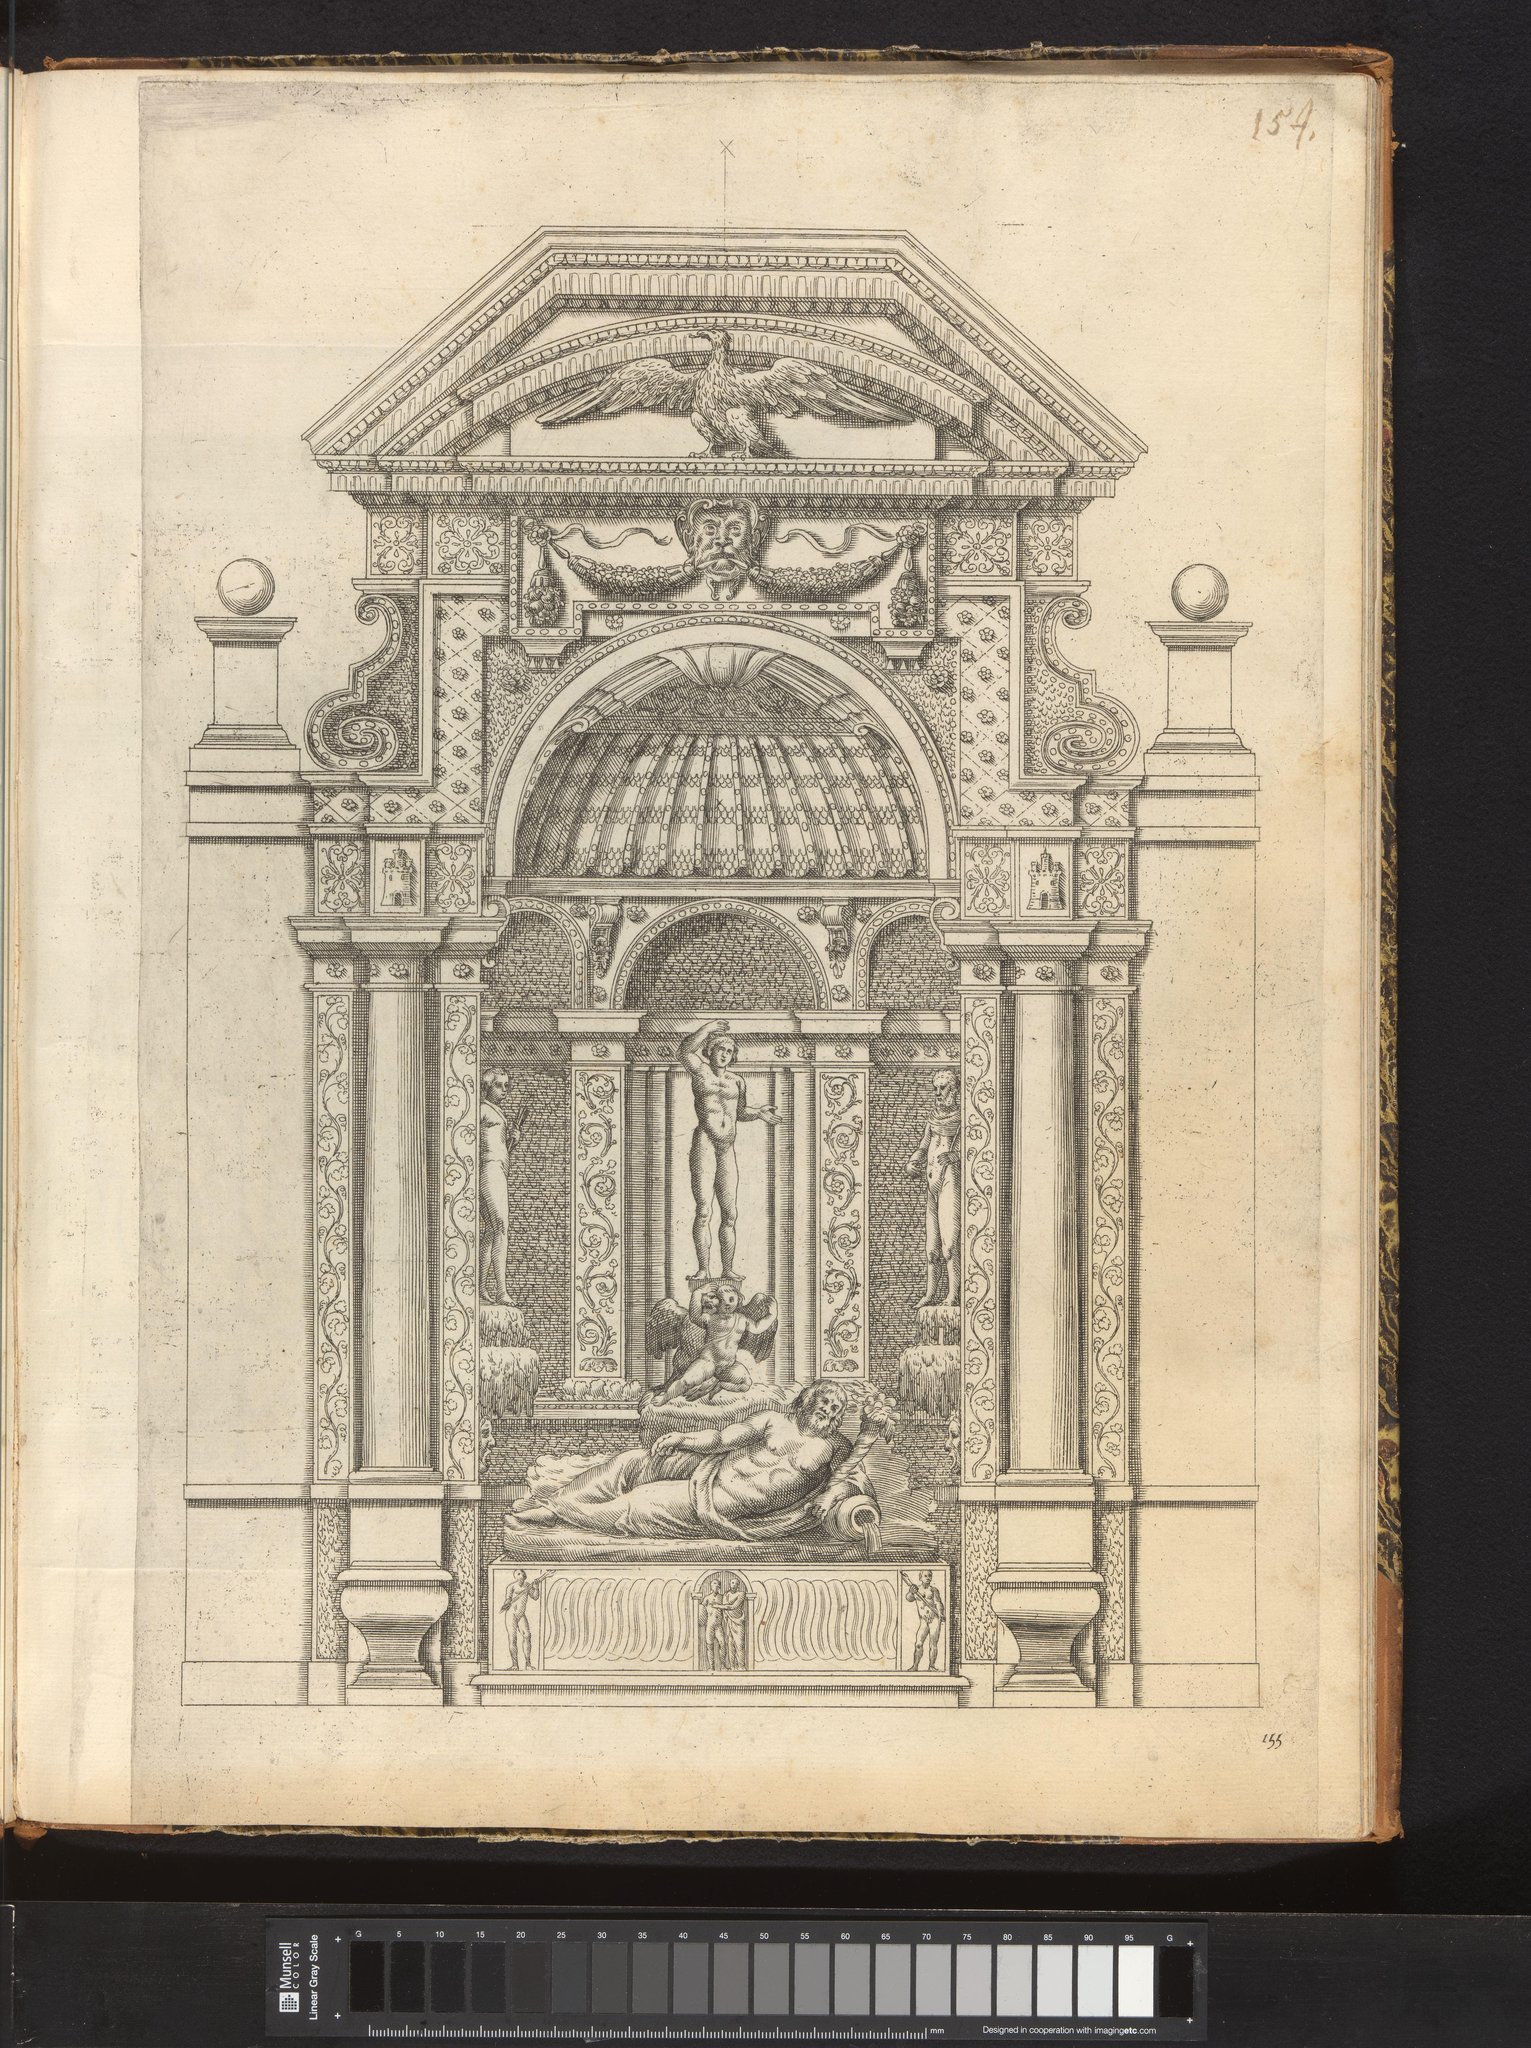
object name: album leaf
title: Aanzicht van het Casino del Giardino bij Sint-Jan van Lateranen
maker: matthäus greuter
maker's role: print maker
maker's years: 1564-1638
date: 1636-1647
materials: paper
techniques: engraving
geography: rome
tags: civic architecture; edifices; dwellings, rome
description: Vooraanzicht van het Casino del Giardino bij Sint-Jan van Lateranen. Boven de poort het wapenschild van de familie Giustiniani. Prent maakt deel uit van een album met een serie prenten naar de sculpturen in de verzameling in de Galleria Giustiniani te Rome.